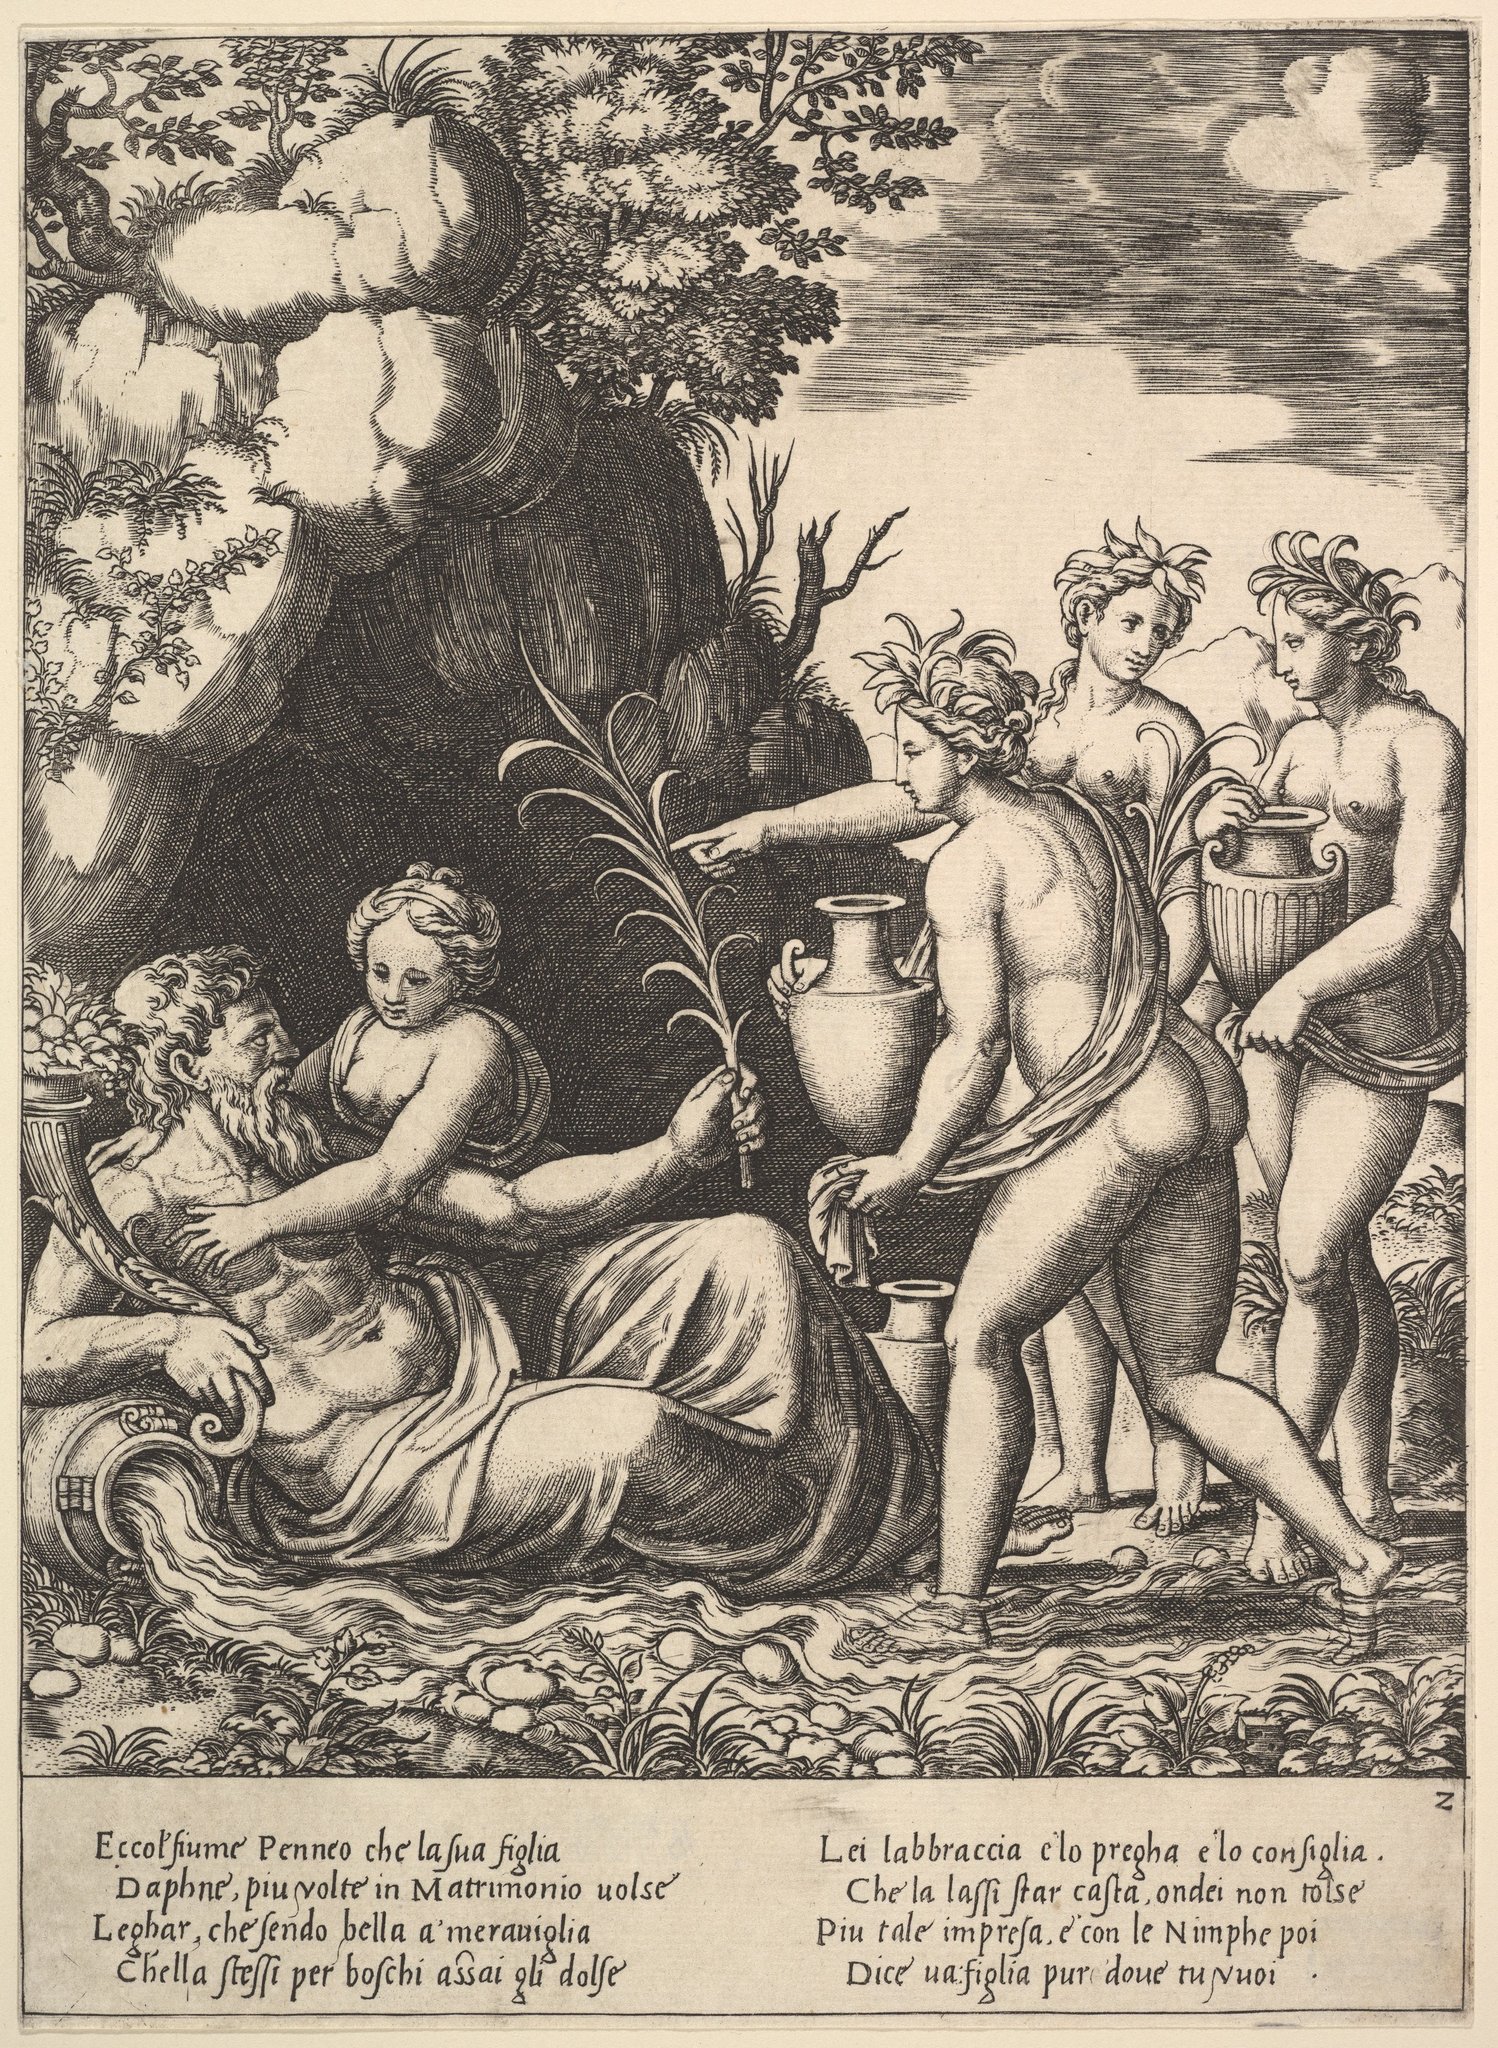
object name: print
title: Daphne embracing her father, the river-god Peneus, at the left three nymphs bring jars from "Story of Apollo and Daphne"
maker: master of the die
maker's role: artist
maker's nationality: italian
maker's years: 1525-1560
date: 1530-1560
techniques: engraving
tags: men,female nudes,nymphs